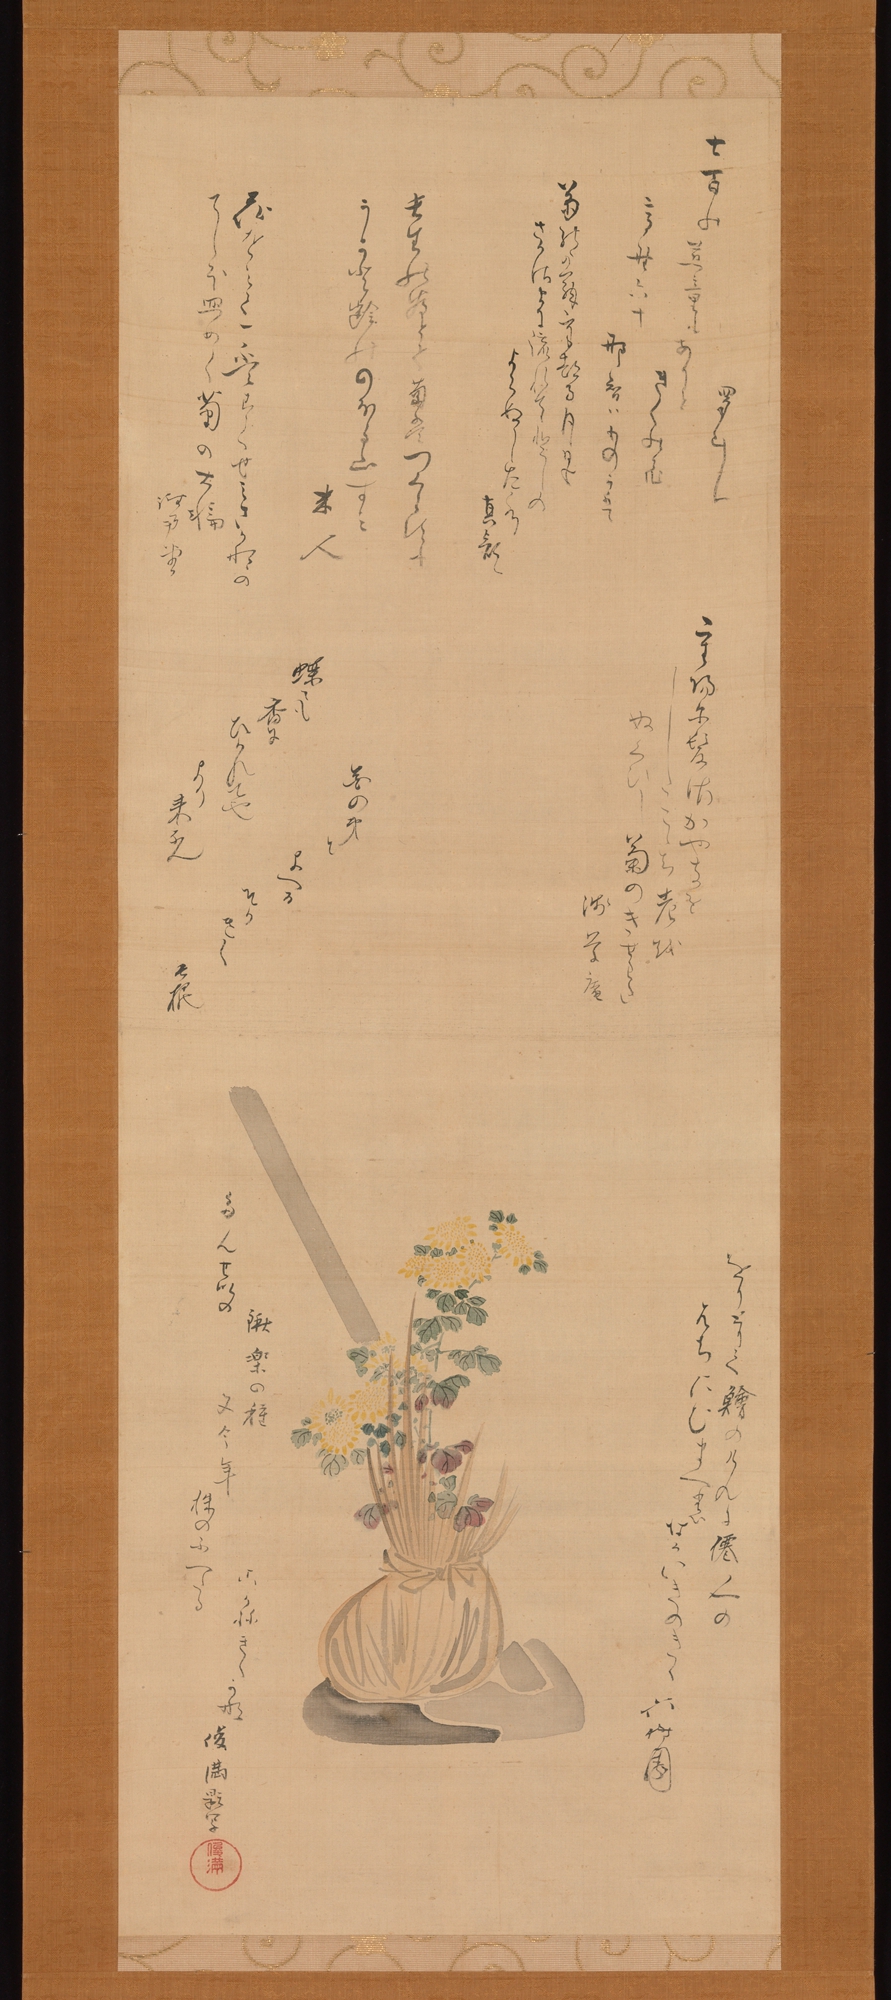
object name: hanging scroll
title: Chrysanthemum and Hoe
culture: japanese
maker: kubo shunman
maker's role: artist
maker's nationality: japanese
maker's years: 1757-1820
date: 1801-1833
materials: ink, silk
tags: flowers